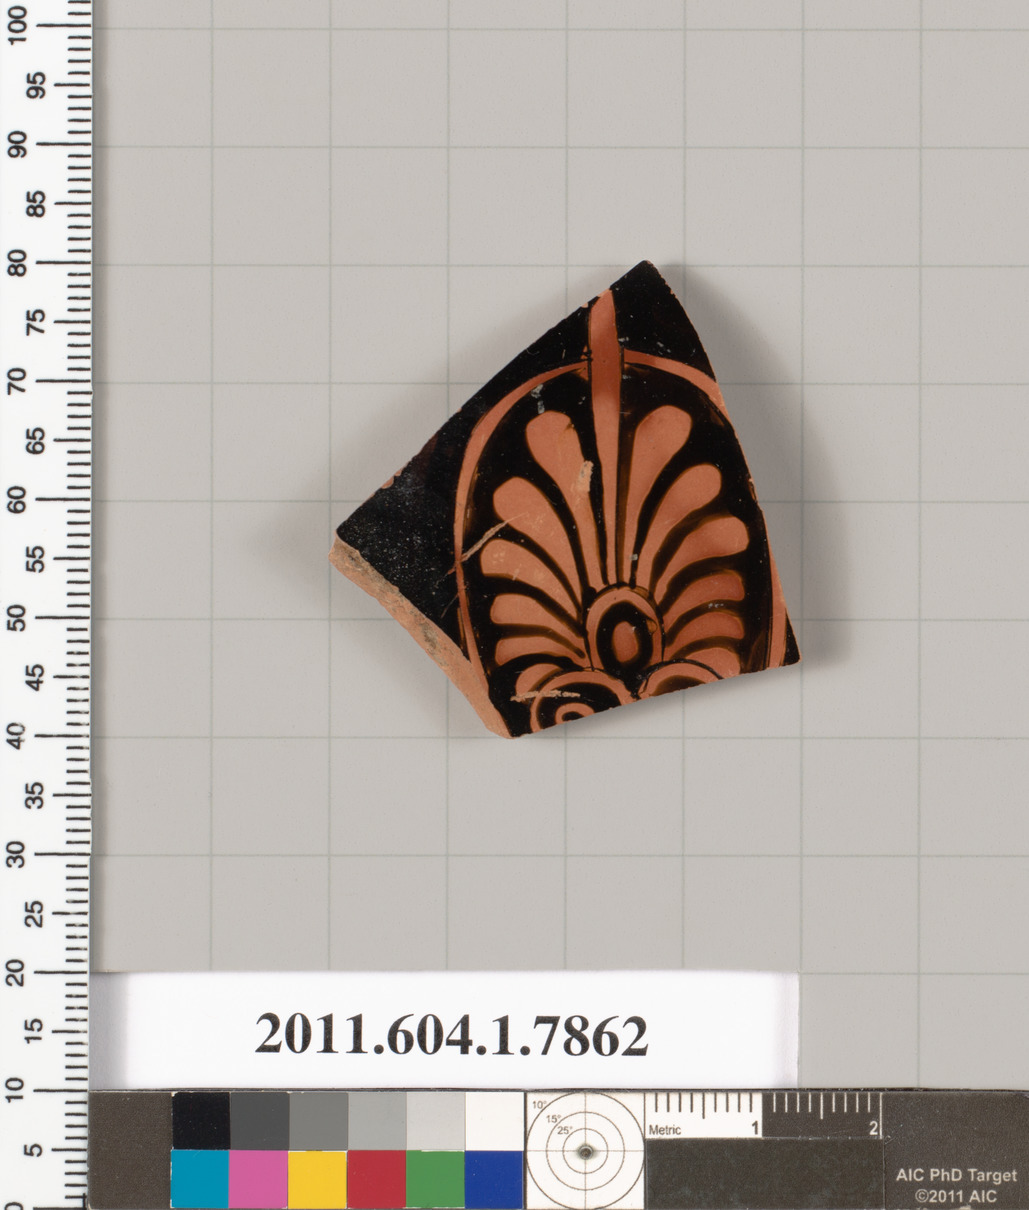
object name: kylix fragment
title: Terracotta fragment of a kylix (drinking cup)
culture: greek, attic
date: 440-420 BCE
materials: terracotta